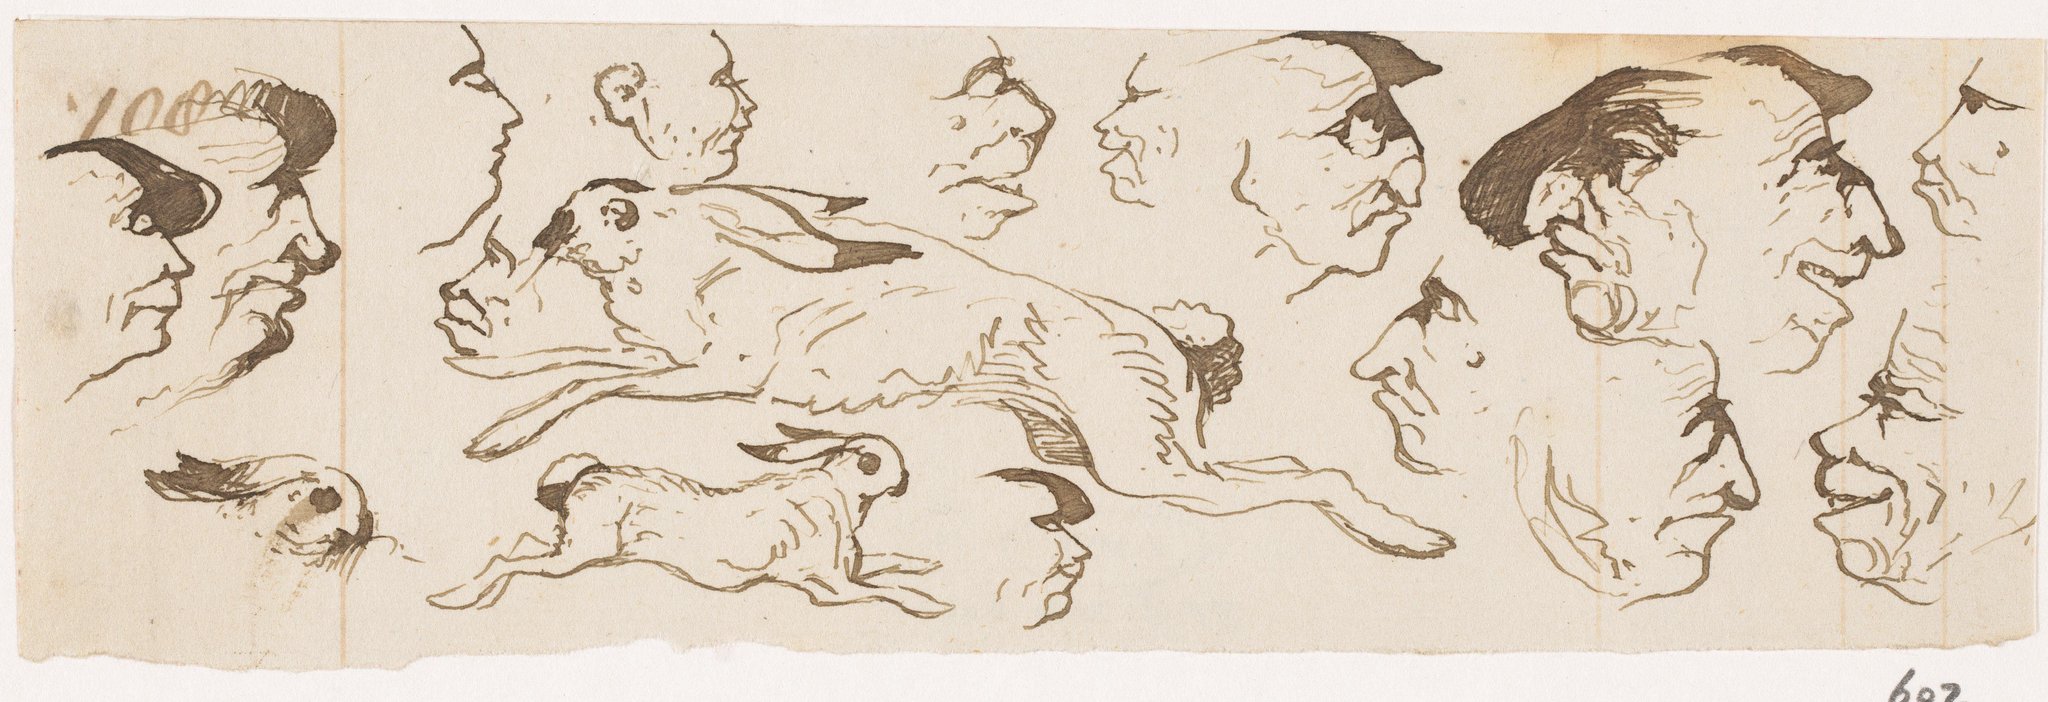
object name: drawing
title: Koppen en hazen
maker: johannes tavenraat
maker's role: draughtsman, painter, print maker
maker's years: 1809-1881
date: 1840-1880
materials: ink, paper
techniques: pen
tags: caricatures (human types), rodents: hare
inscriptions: collector's mark: Lugt 2228